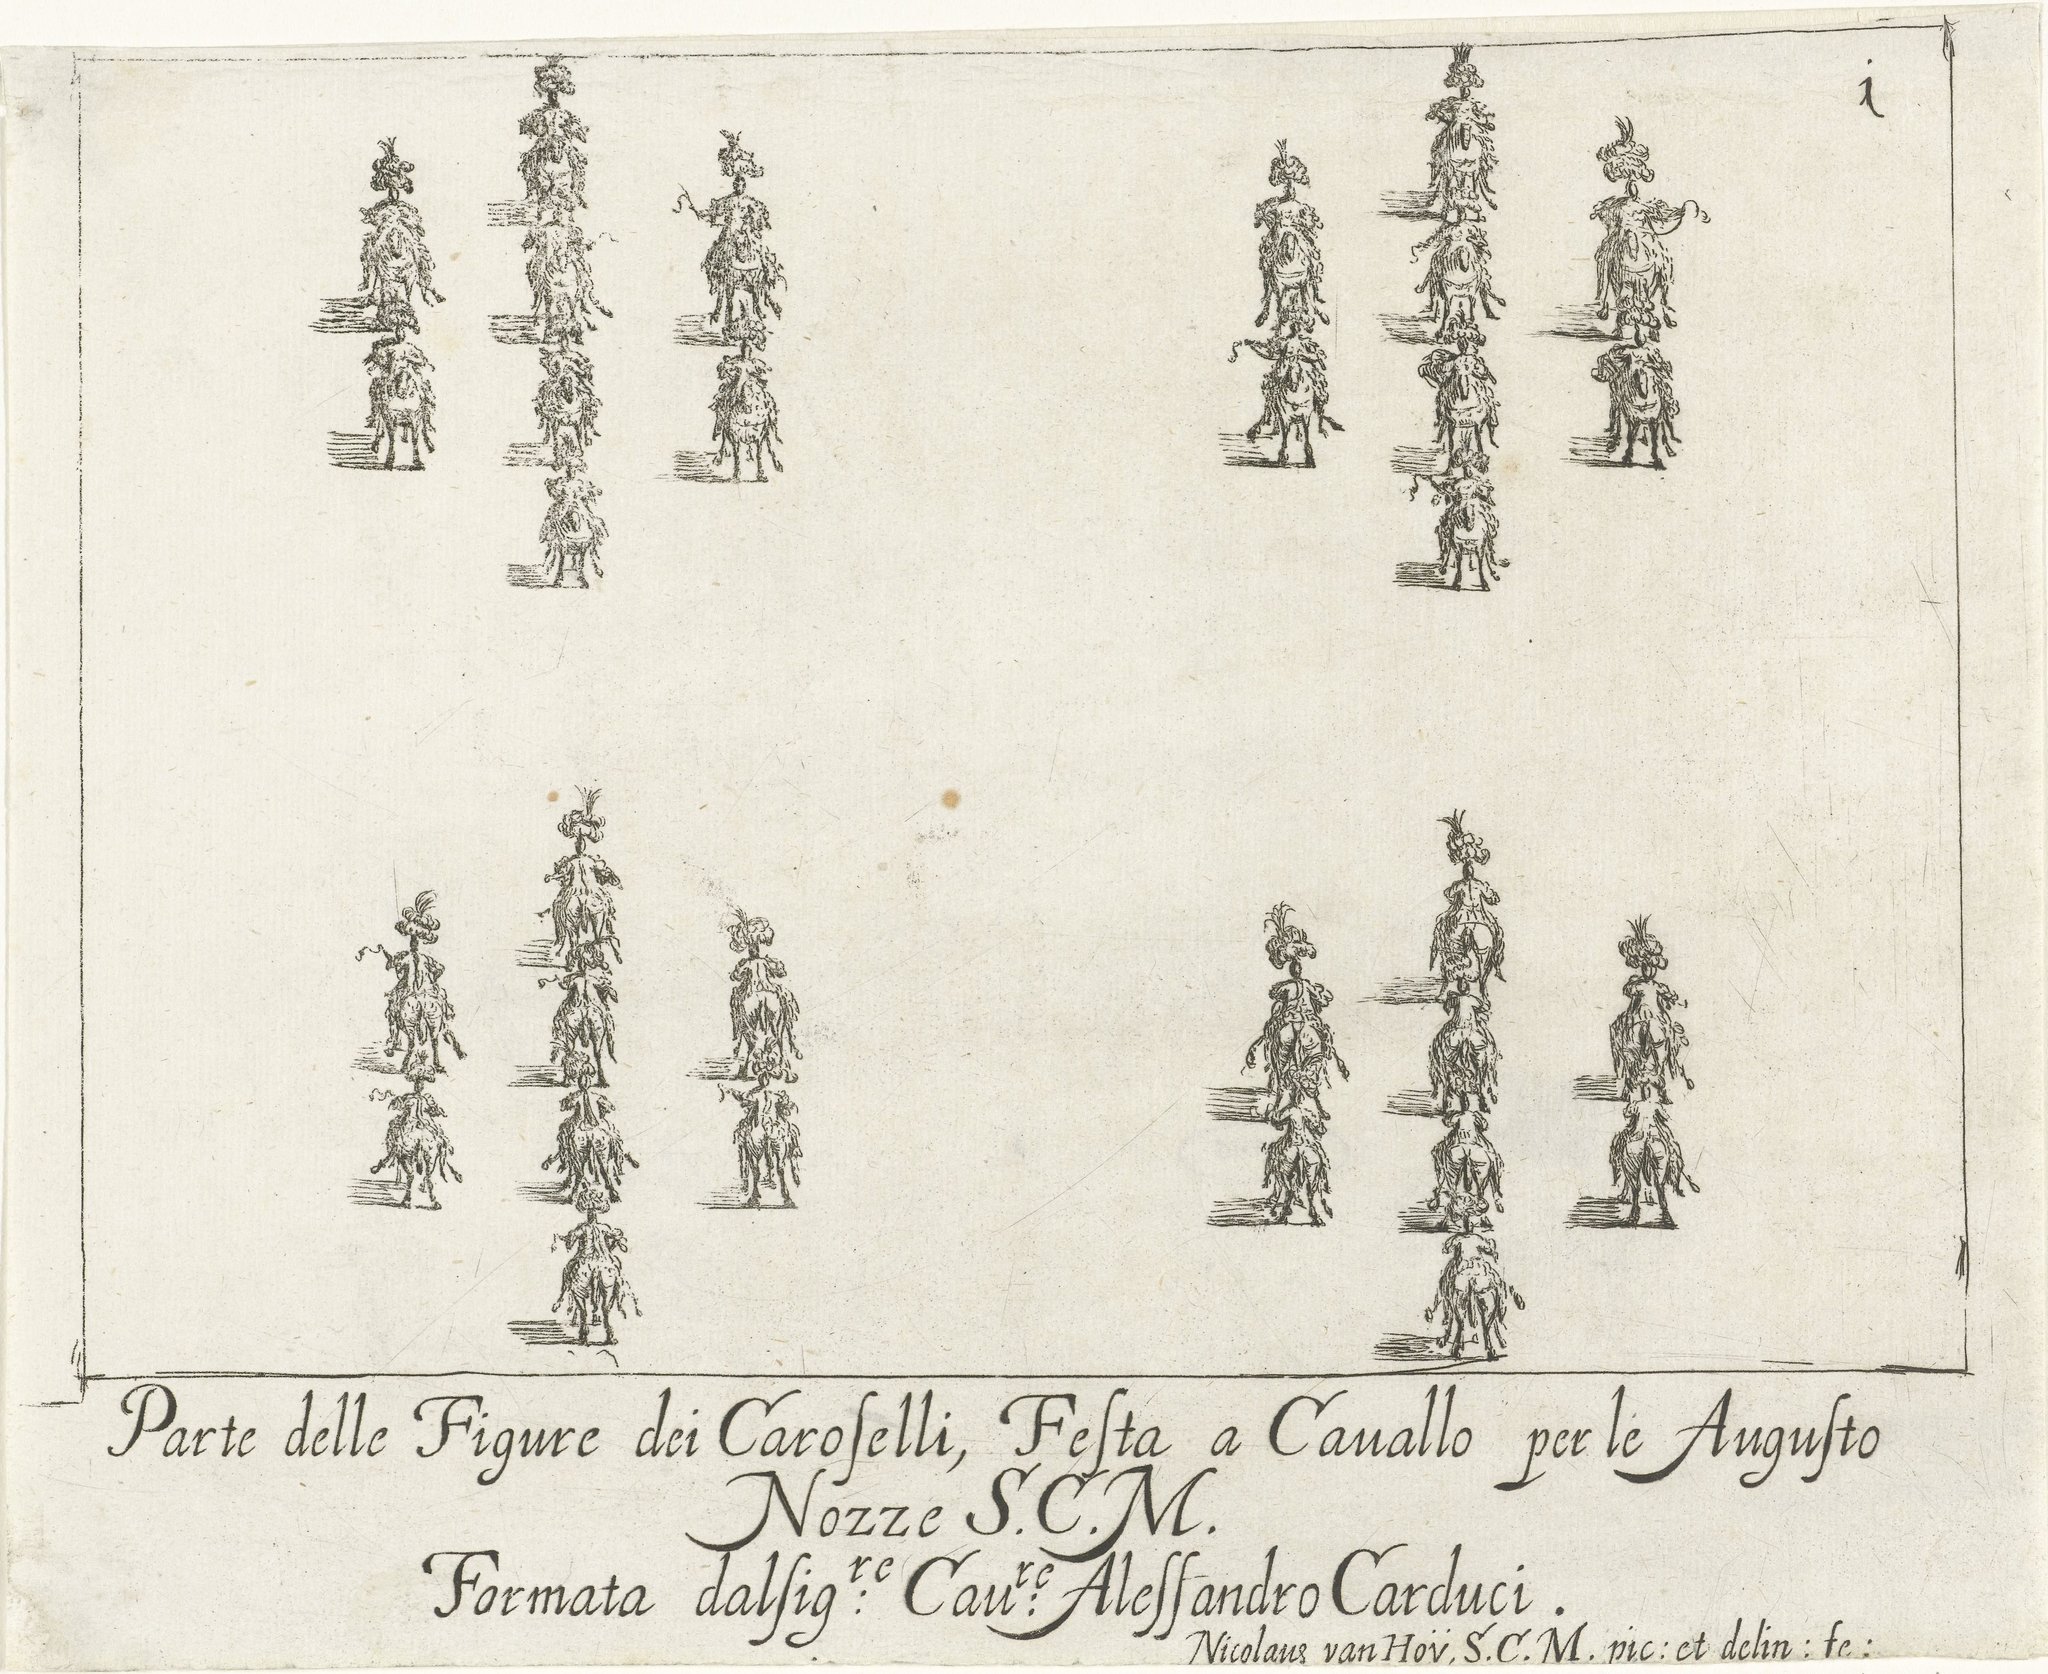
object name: print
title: Vier groepen ruiters in rust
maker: nikolaas van hoy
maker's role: draughtsman, painter, print maker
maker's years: 1631-1679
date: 1667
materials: paper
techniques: etching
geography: vienna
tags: military honours (+ cavalry, horsemen), carrousel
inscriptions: collector's mark: Lugt 2228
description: Vier groepen ruiters in rust. Eerste prent van een serie van prenten met ruiterformaties behorende bij het carrouselrijden, opgevoerd tijdens het huwelijk van Leopold I met Margaretha Theresia van Spanje.